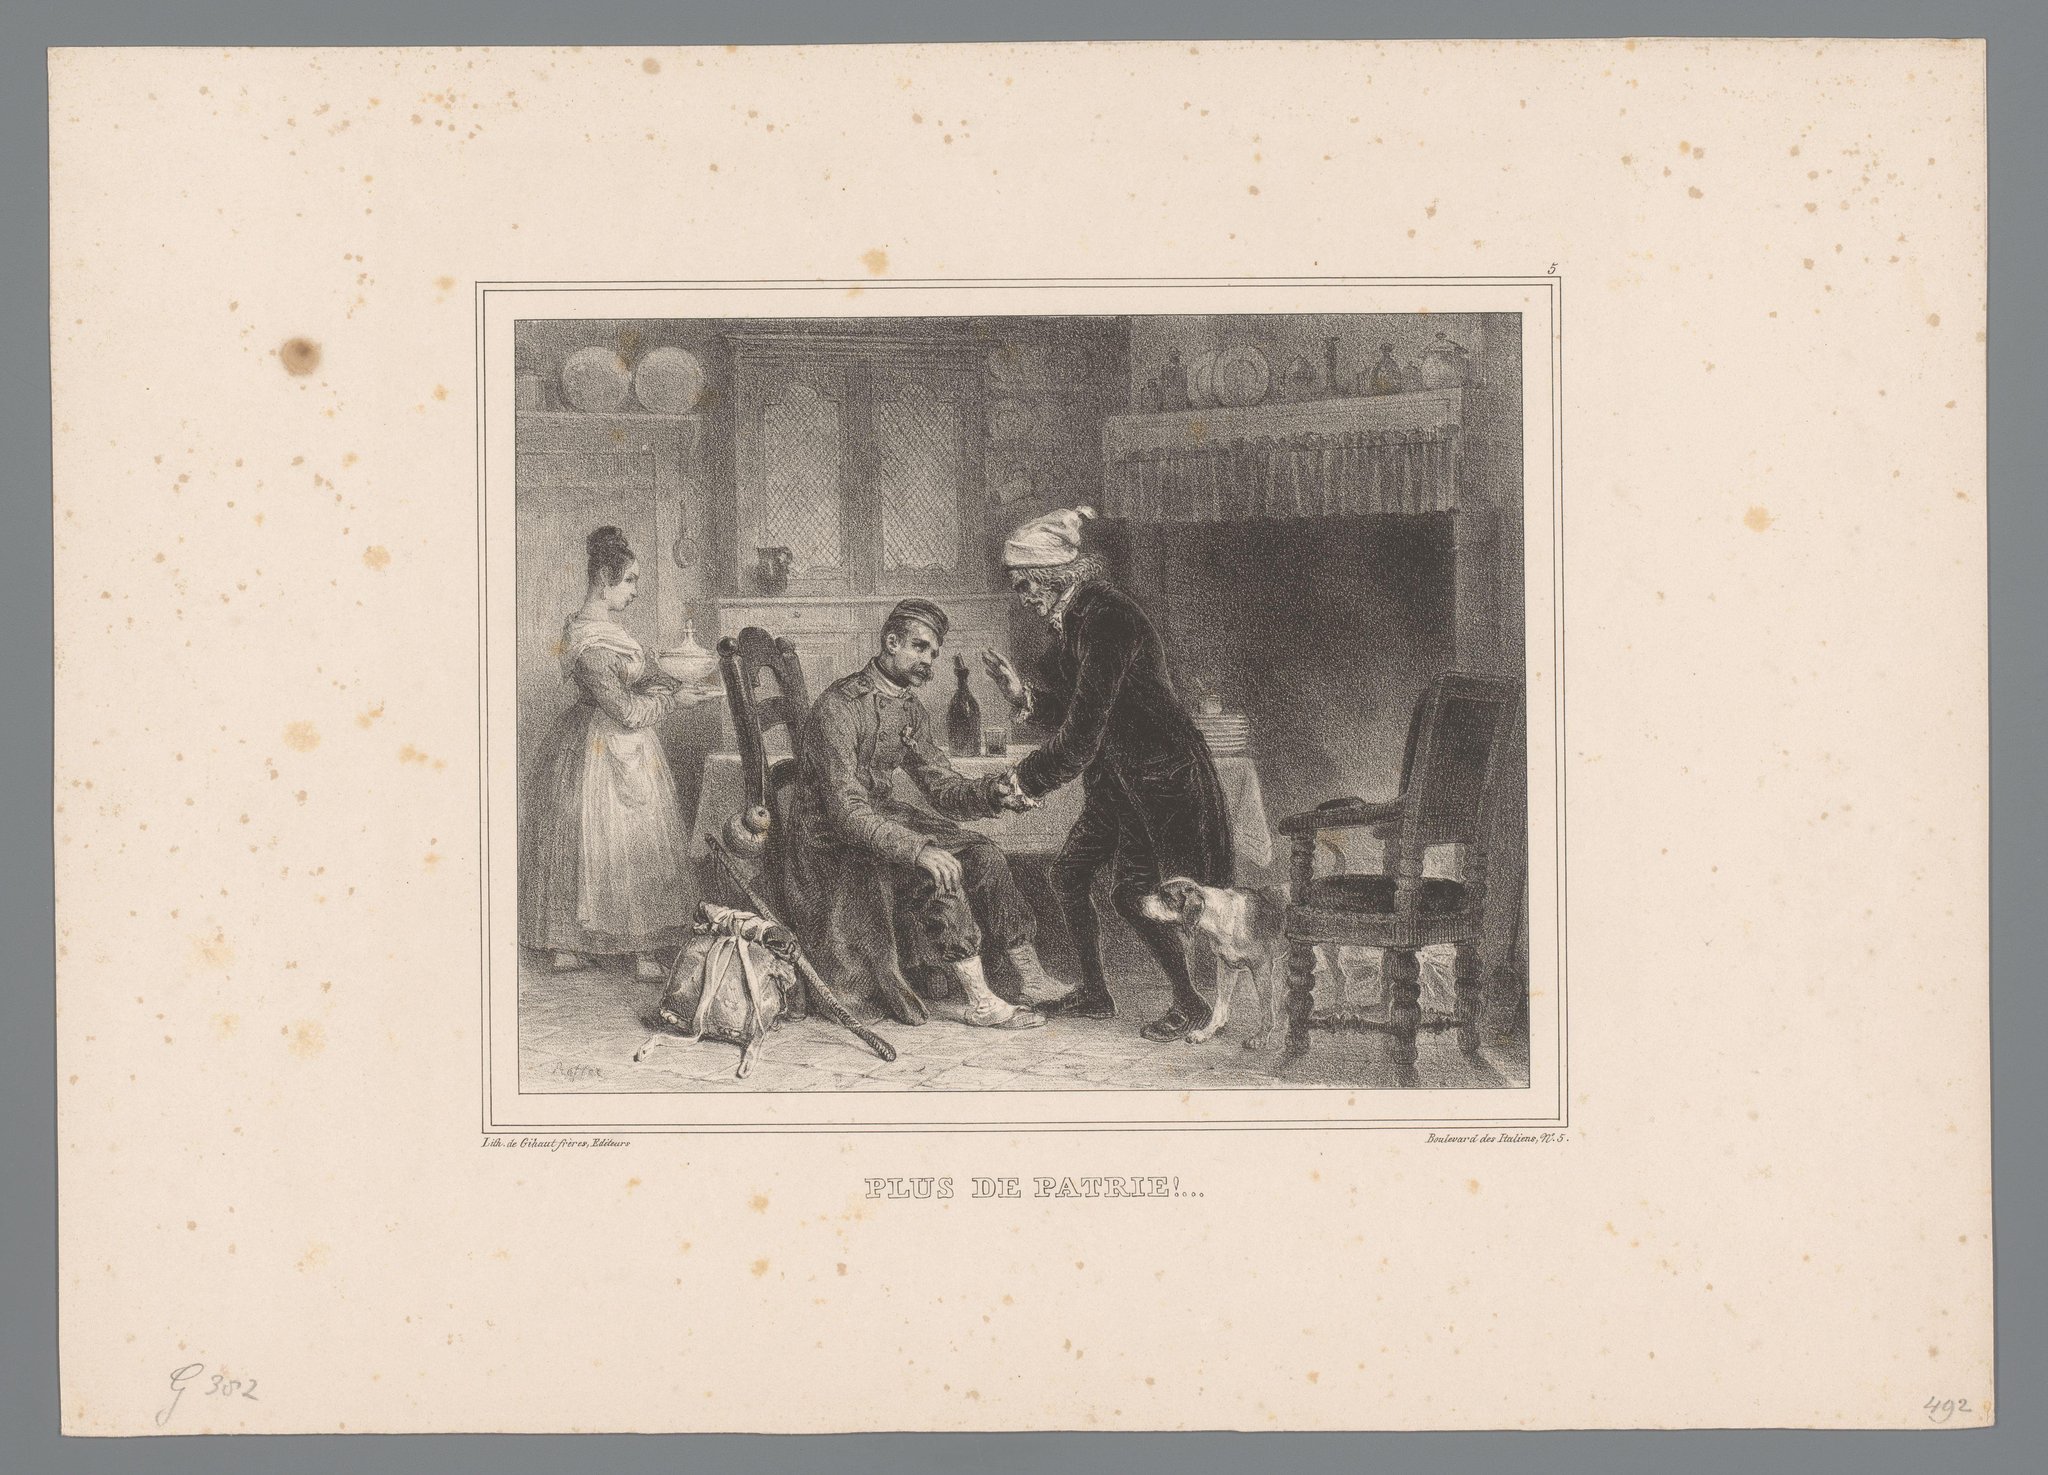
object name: print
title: Album de 1834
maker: denis auguste marie raffet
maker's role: draughtsman, print maker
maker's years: 1804-1860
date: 1834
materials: paper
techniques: lithograph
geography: paris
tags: old man, the soldier; the soldier's life, baton of general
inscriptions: collector's mark: Lugt 2228